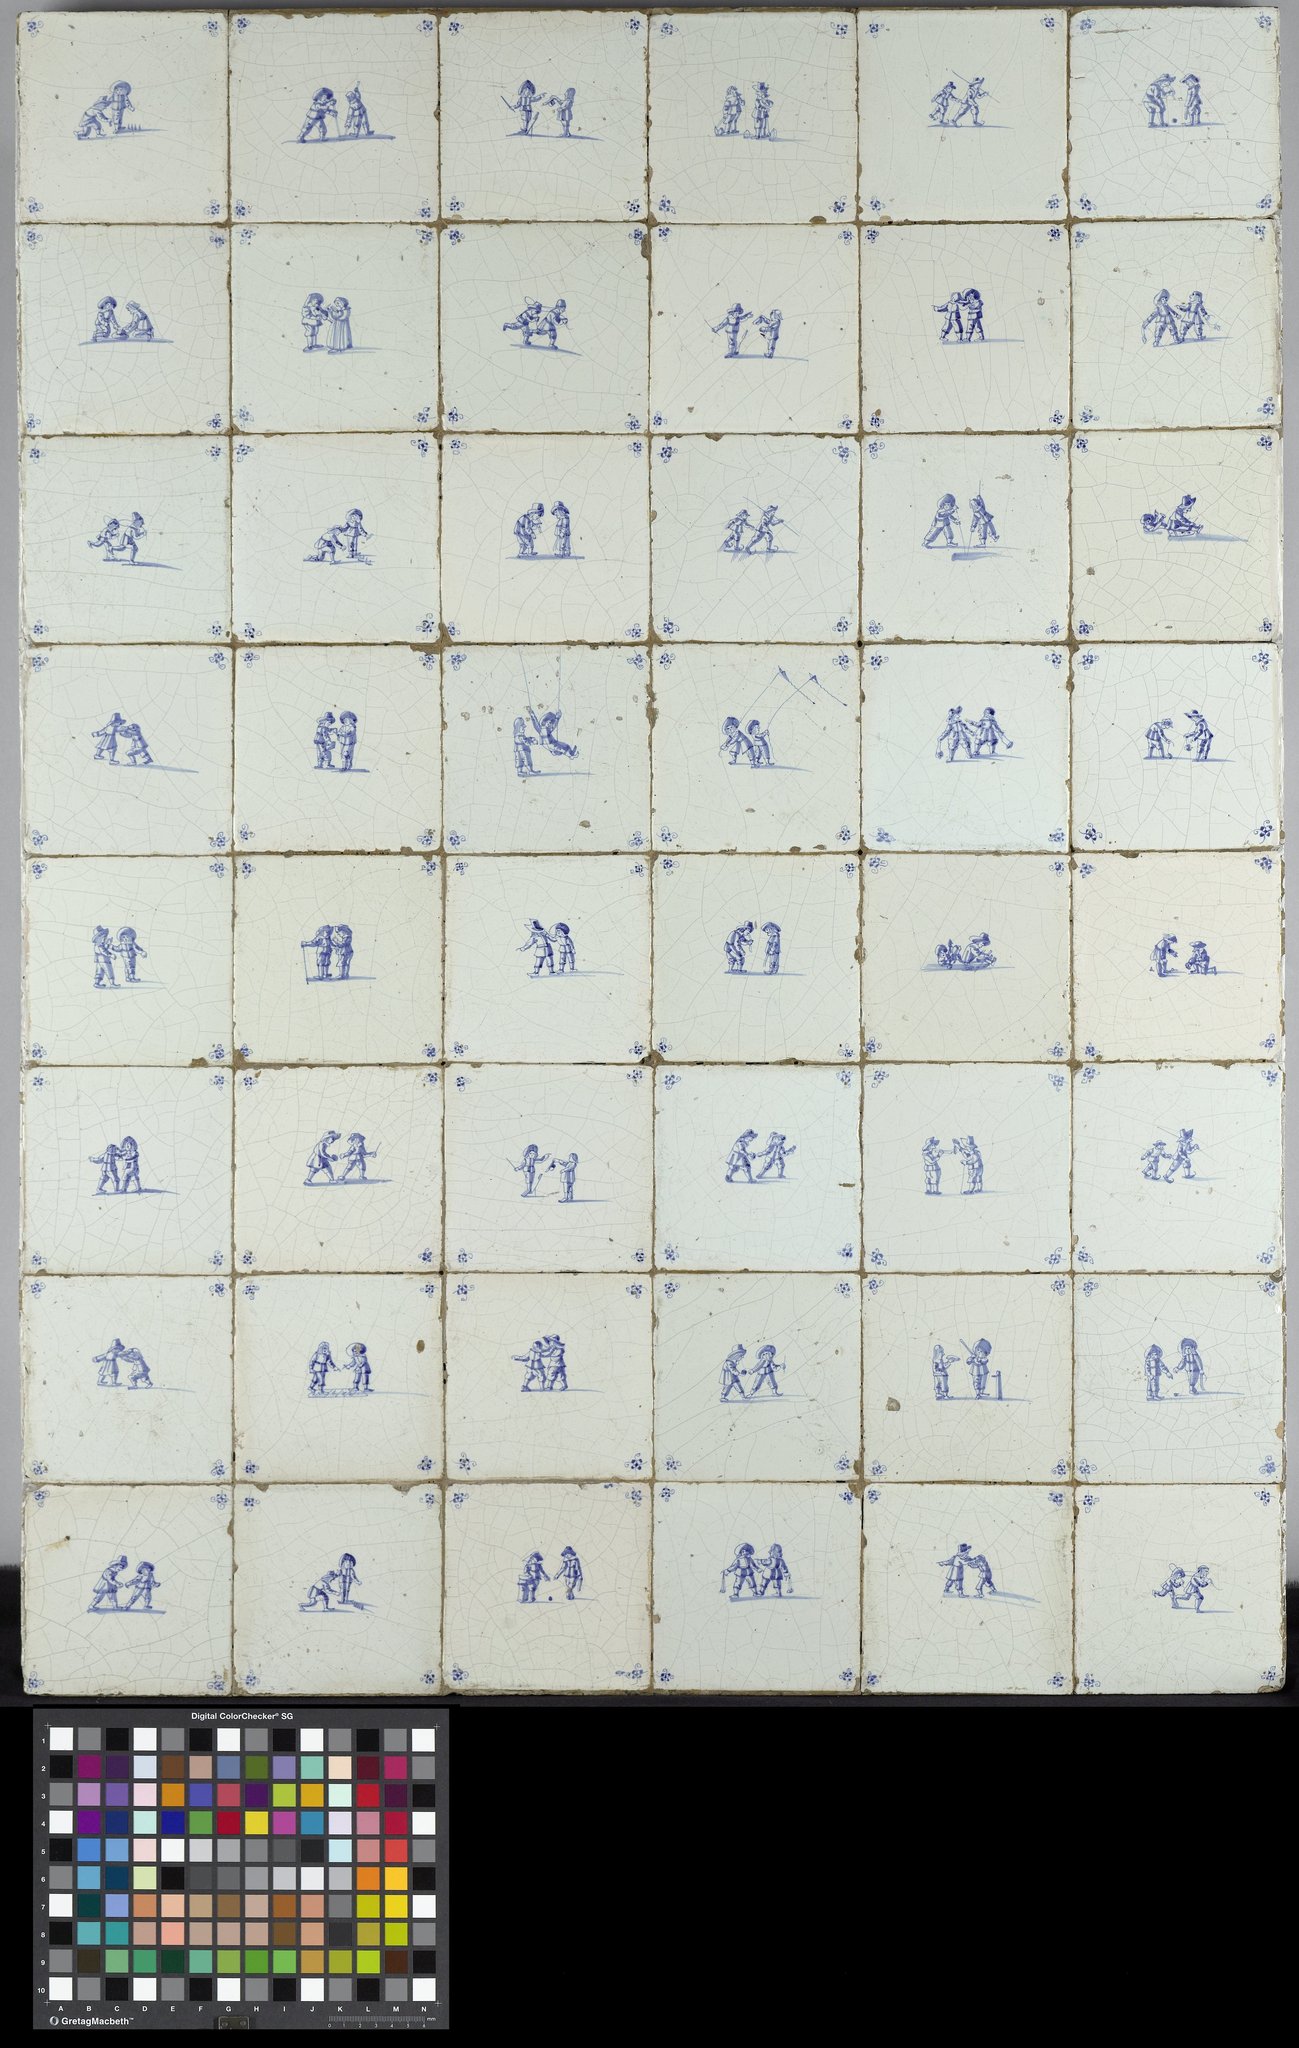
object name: tegelveld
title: Tiles with Scenes of Children Playing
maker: Anonymous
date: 1680-1730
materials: earthenware, glaze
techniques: maiolica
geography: netherlands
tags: children's games and plays, spiders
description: Veld van achtenveertig kinderspeltegels (8 x 6) elk met een blauw geschilderde voorstelling van twee spelende kinderen. In de hoeken, een spinnetje.